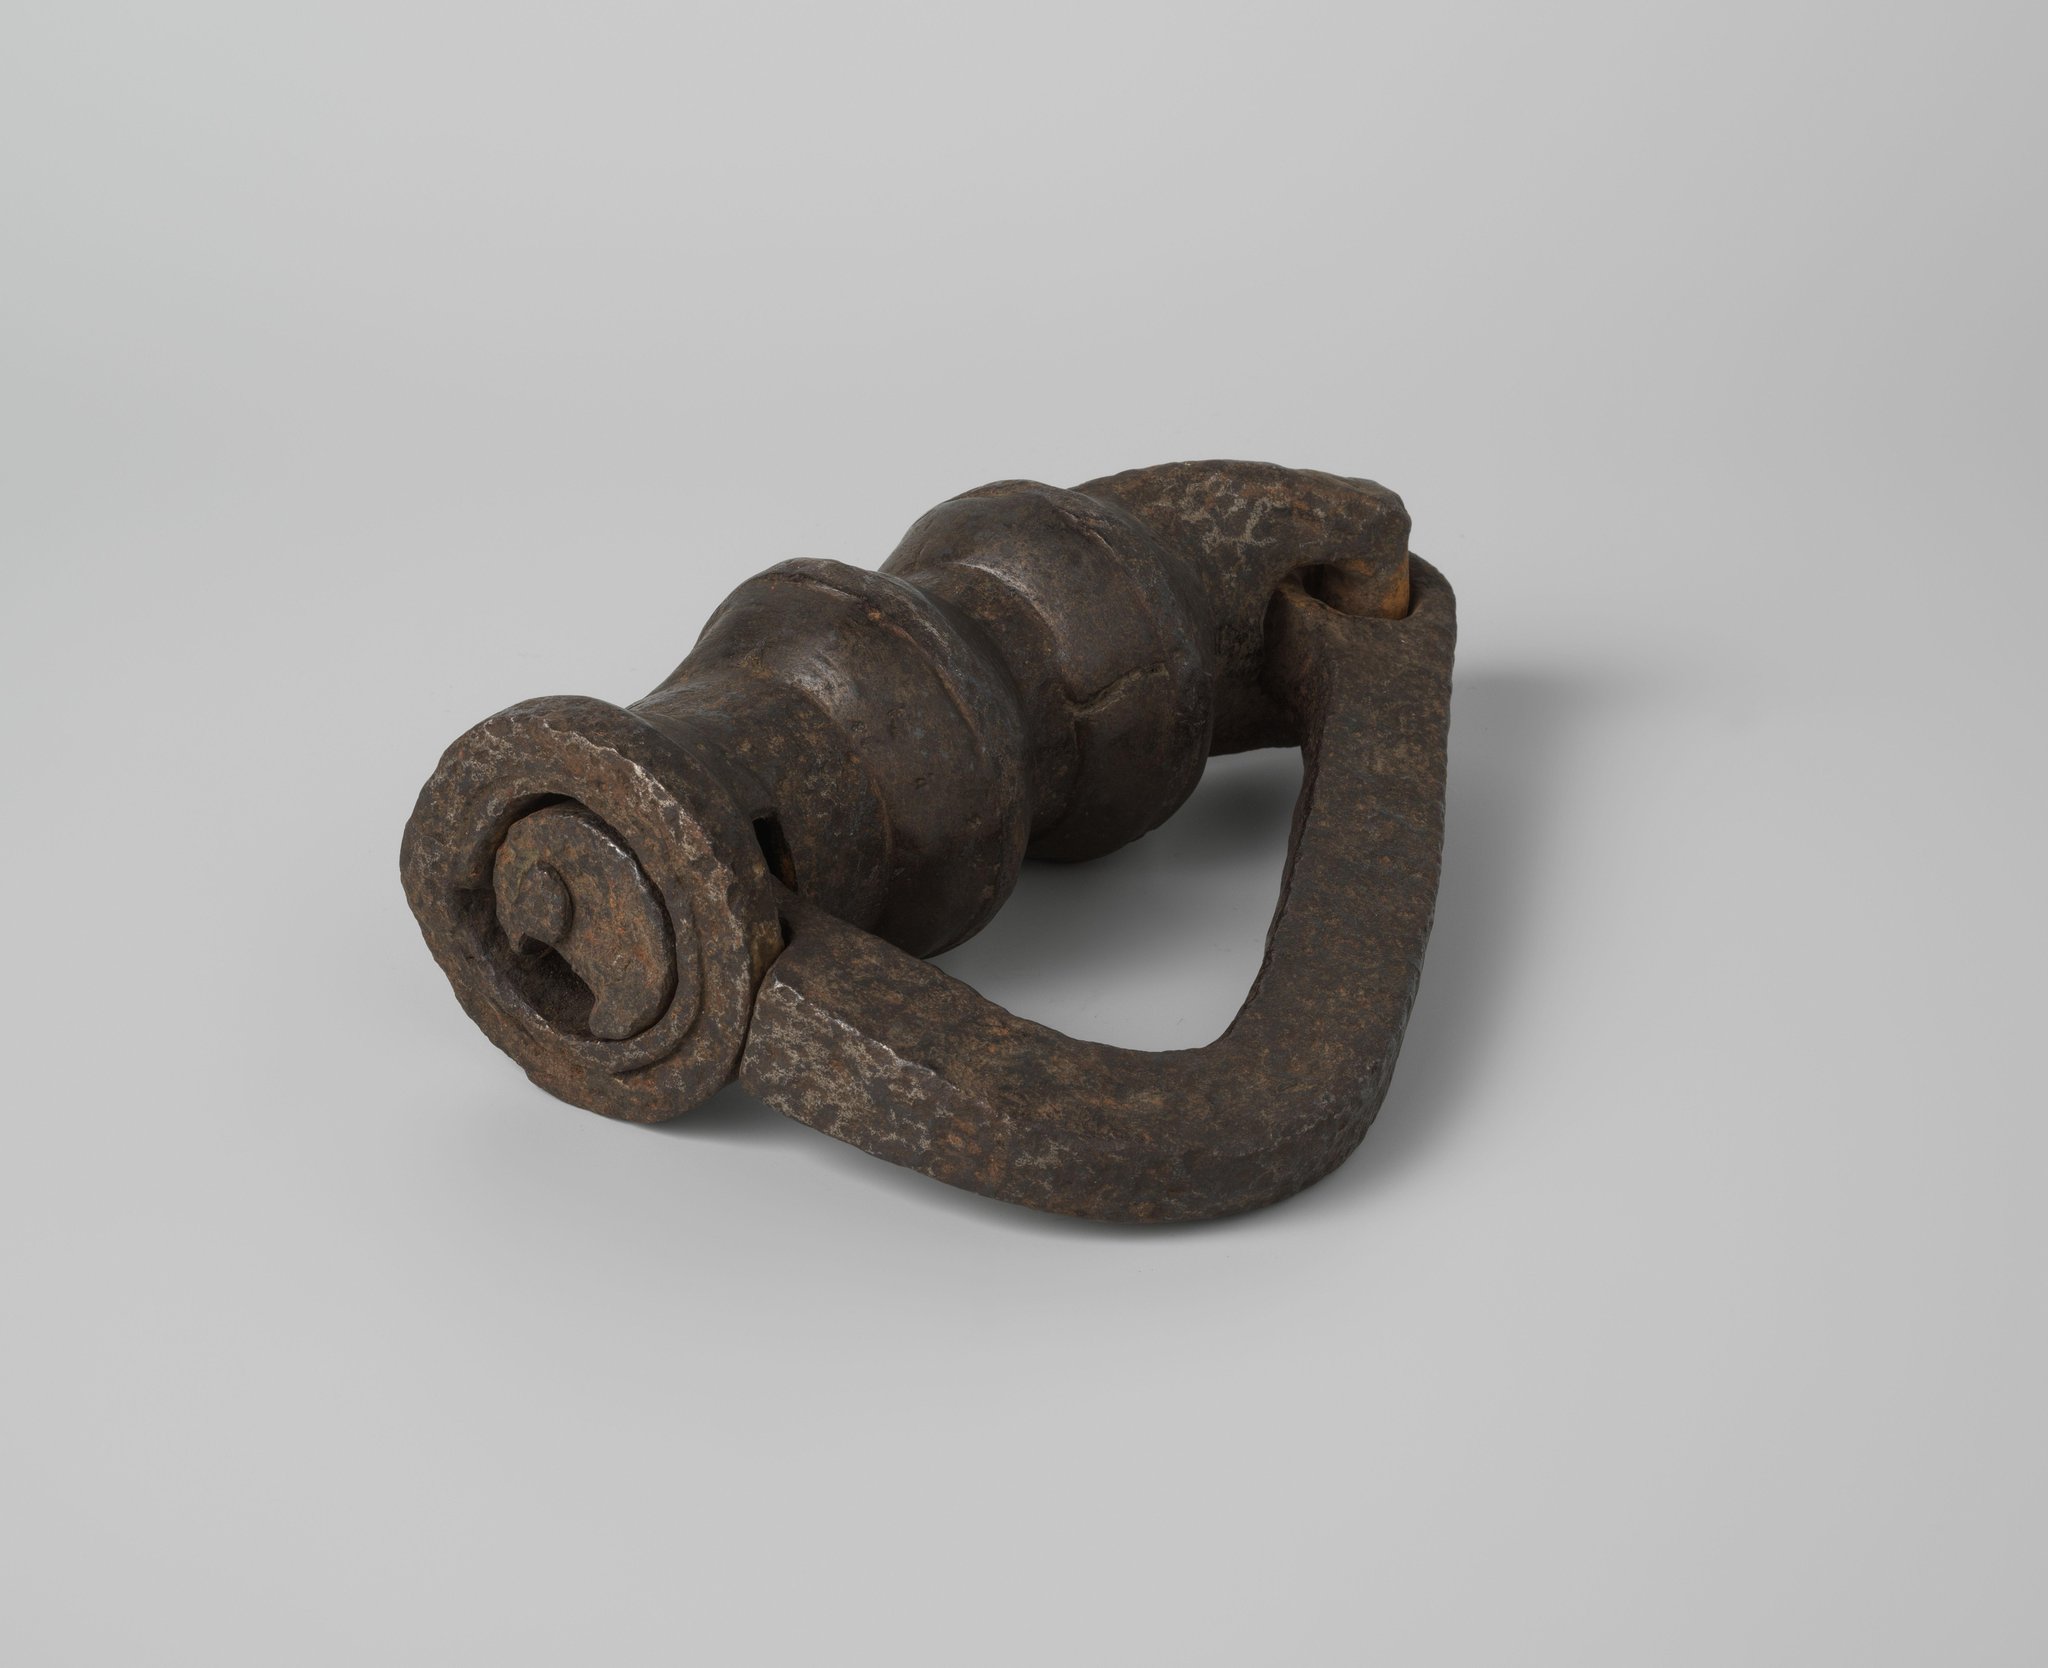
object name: padlock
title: Hangslot met cilindervormige hamer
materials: iron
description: Een ijzeren hangslot met een cylindervormige hamer.